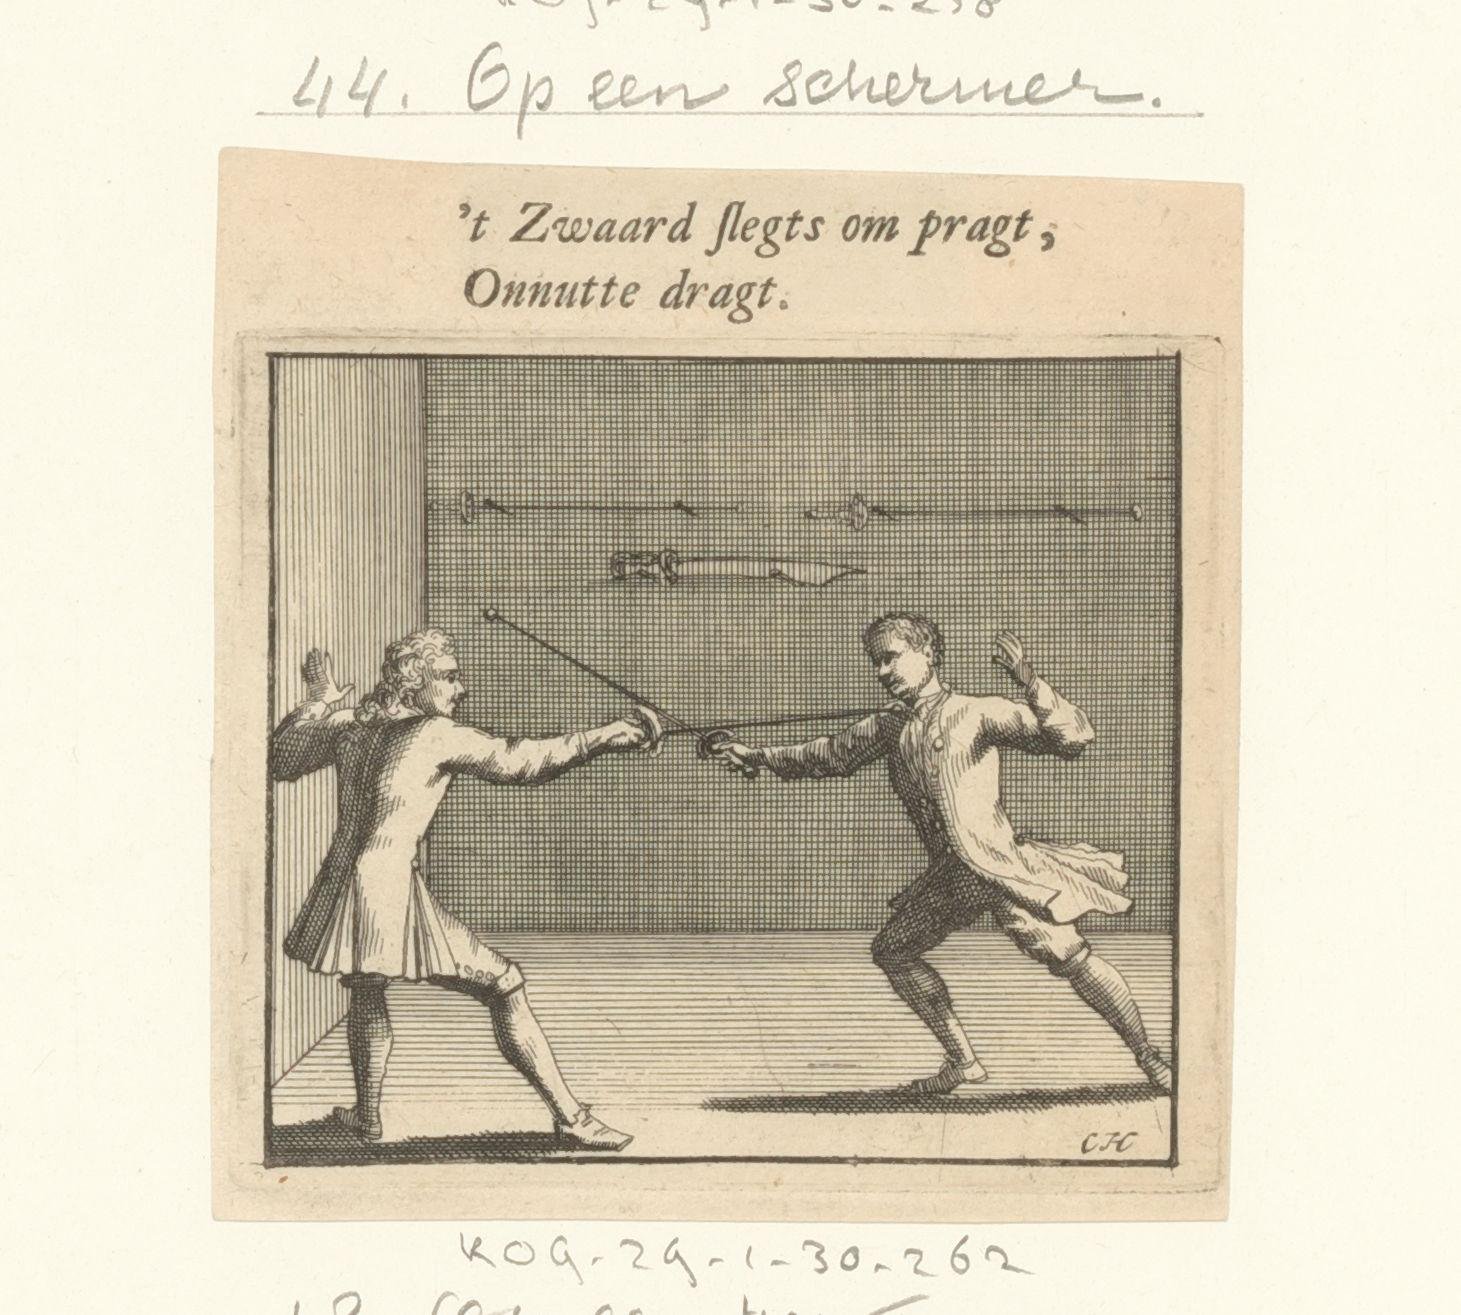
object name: print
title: 't Zwaard slegts om pragt, Onnutte dragt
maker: cornelis huyberts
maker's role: print maker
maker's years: 1669-1709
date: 1725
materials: paper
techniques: etching, letterpress printing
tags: fencing (sport)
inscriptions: stamp, collector's mark: Lugt 1641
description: Prent uit: Graauwhart, Hendrik. Voorbeeldelyke zeede-lessen, genoomen uyt den eersten toestand des werelds (...). Amsterdam: Johannes Ratelband, 1725. Prent ook gebruikt voor eerdere en (1709) latere uitgave (1756, 1761 en 1764).